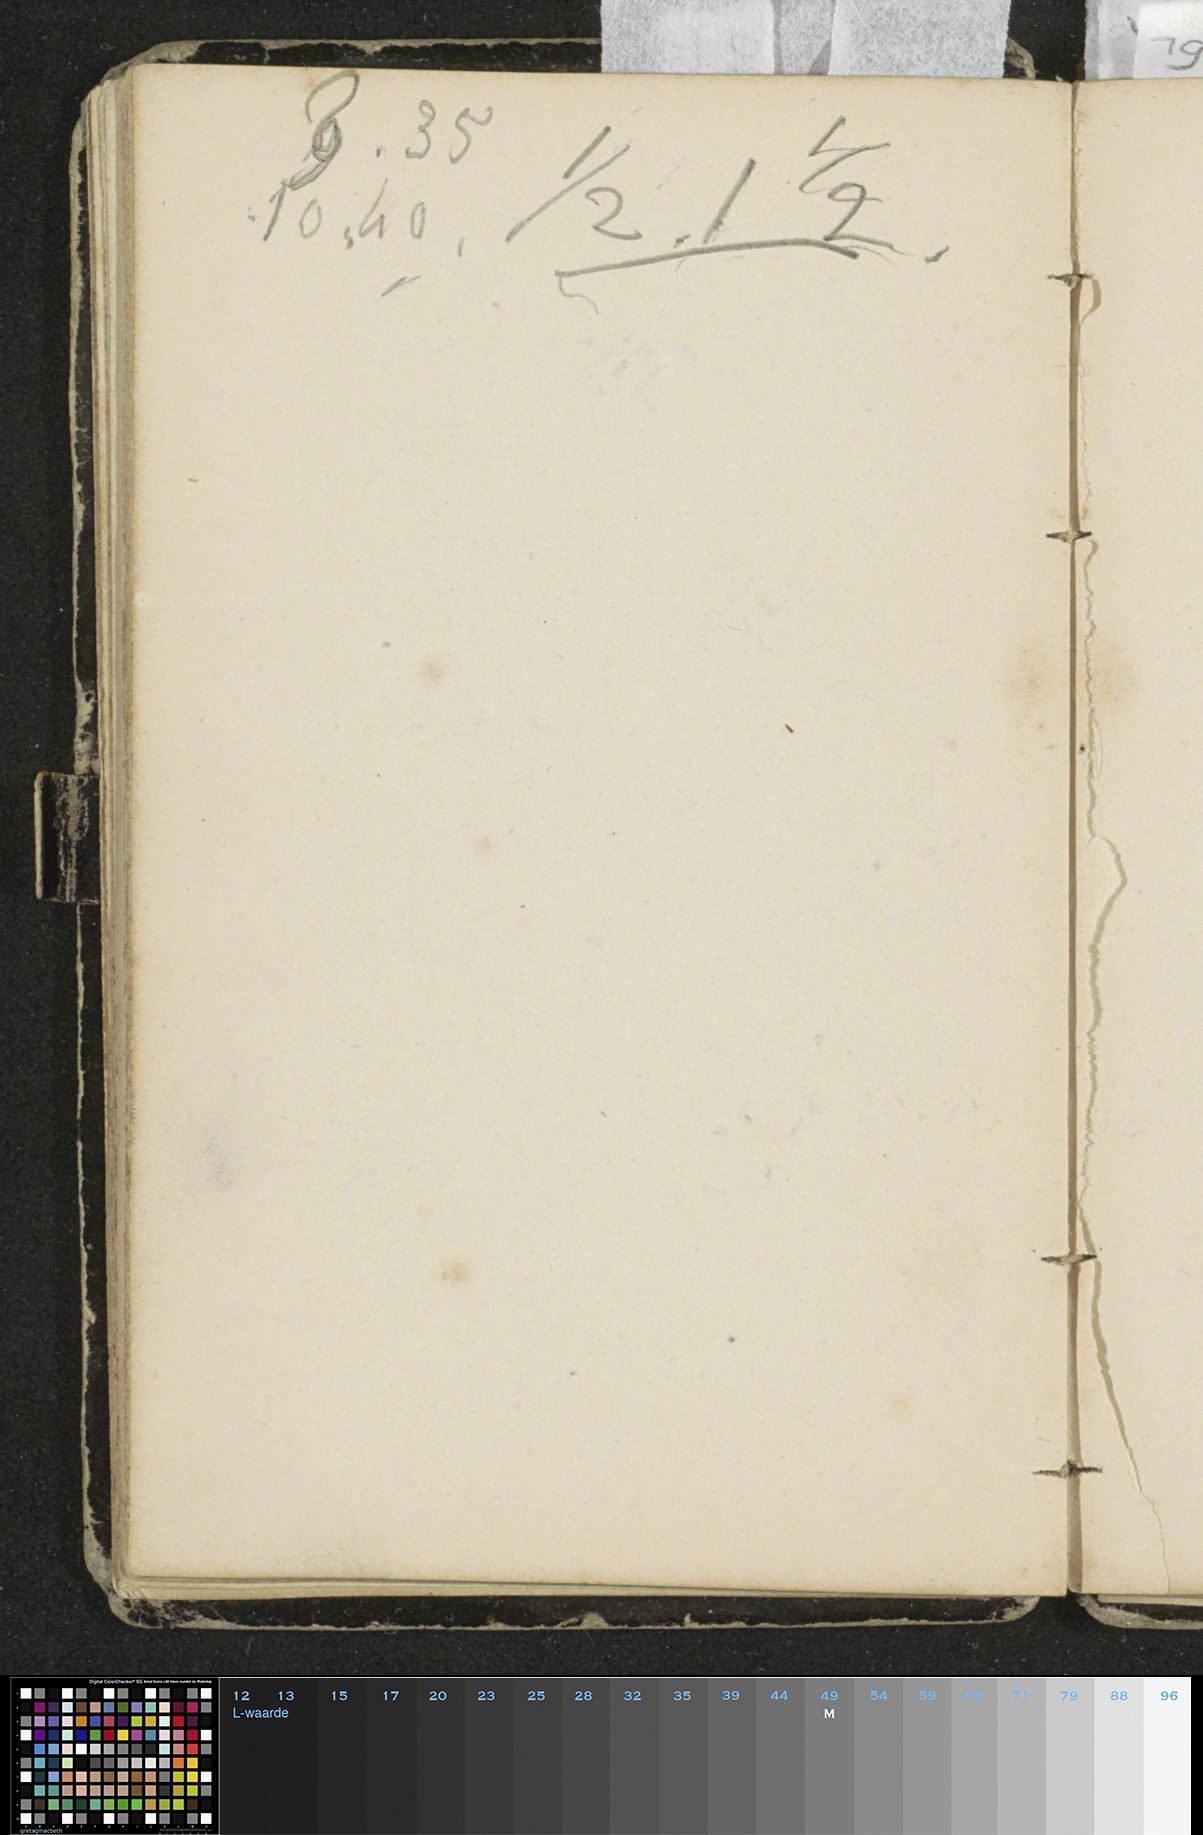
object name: sketchbook leaf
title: Berekeningen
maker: willem koekkoek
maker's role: draughtsman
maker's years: 1839-1895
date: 1849-1895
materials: paper, pencil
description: Blad 18 verso uit een schetsboek met 57 bladen.